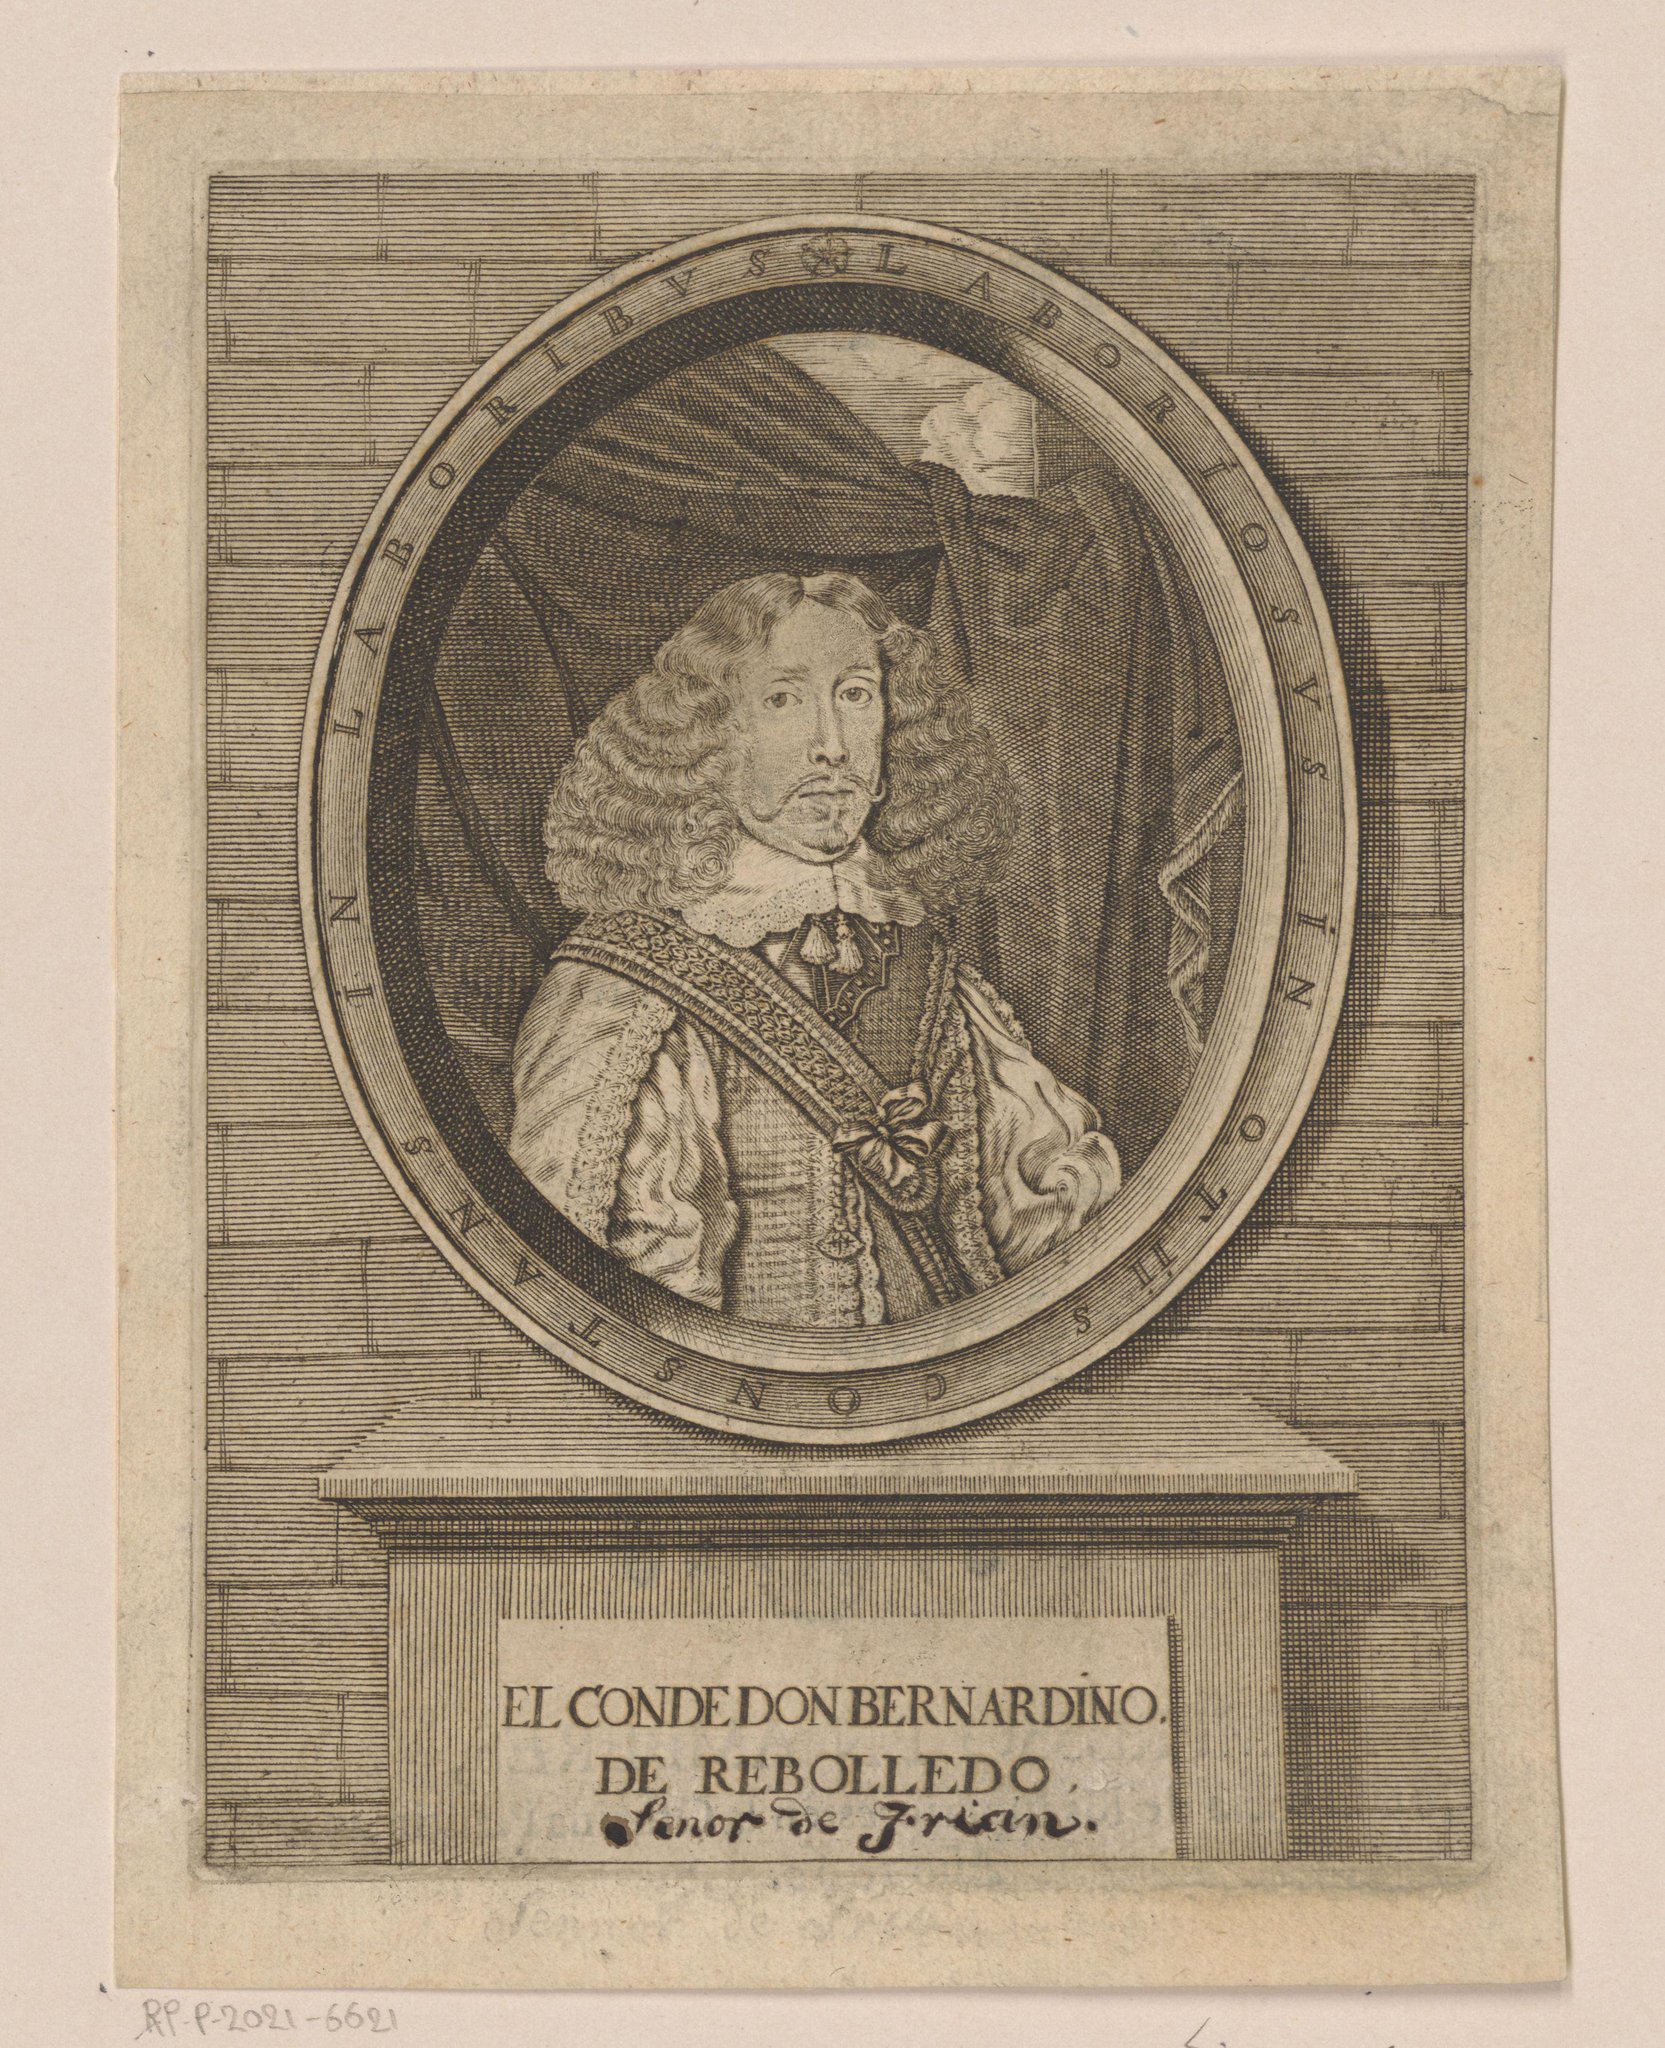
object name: print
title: Portret van Bernardino de Rebolledo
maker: Anonymous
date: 1660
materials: paper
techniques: engraving, letterpress printing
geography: antwerp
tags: historical persons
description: Prent uit: Rebolledo, Bernardino de. Ocios del Conde de Rebolledo (...). Antwerpen: Officina Plantiniana, 1660, dl. 1.